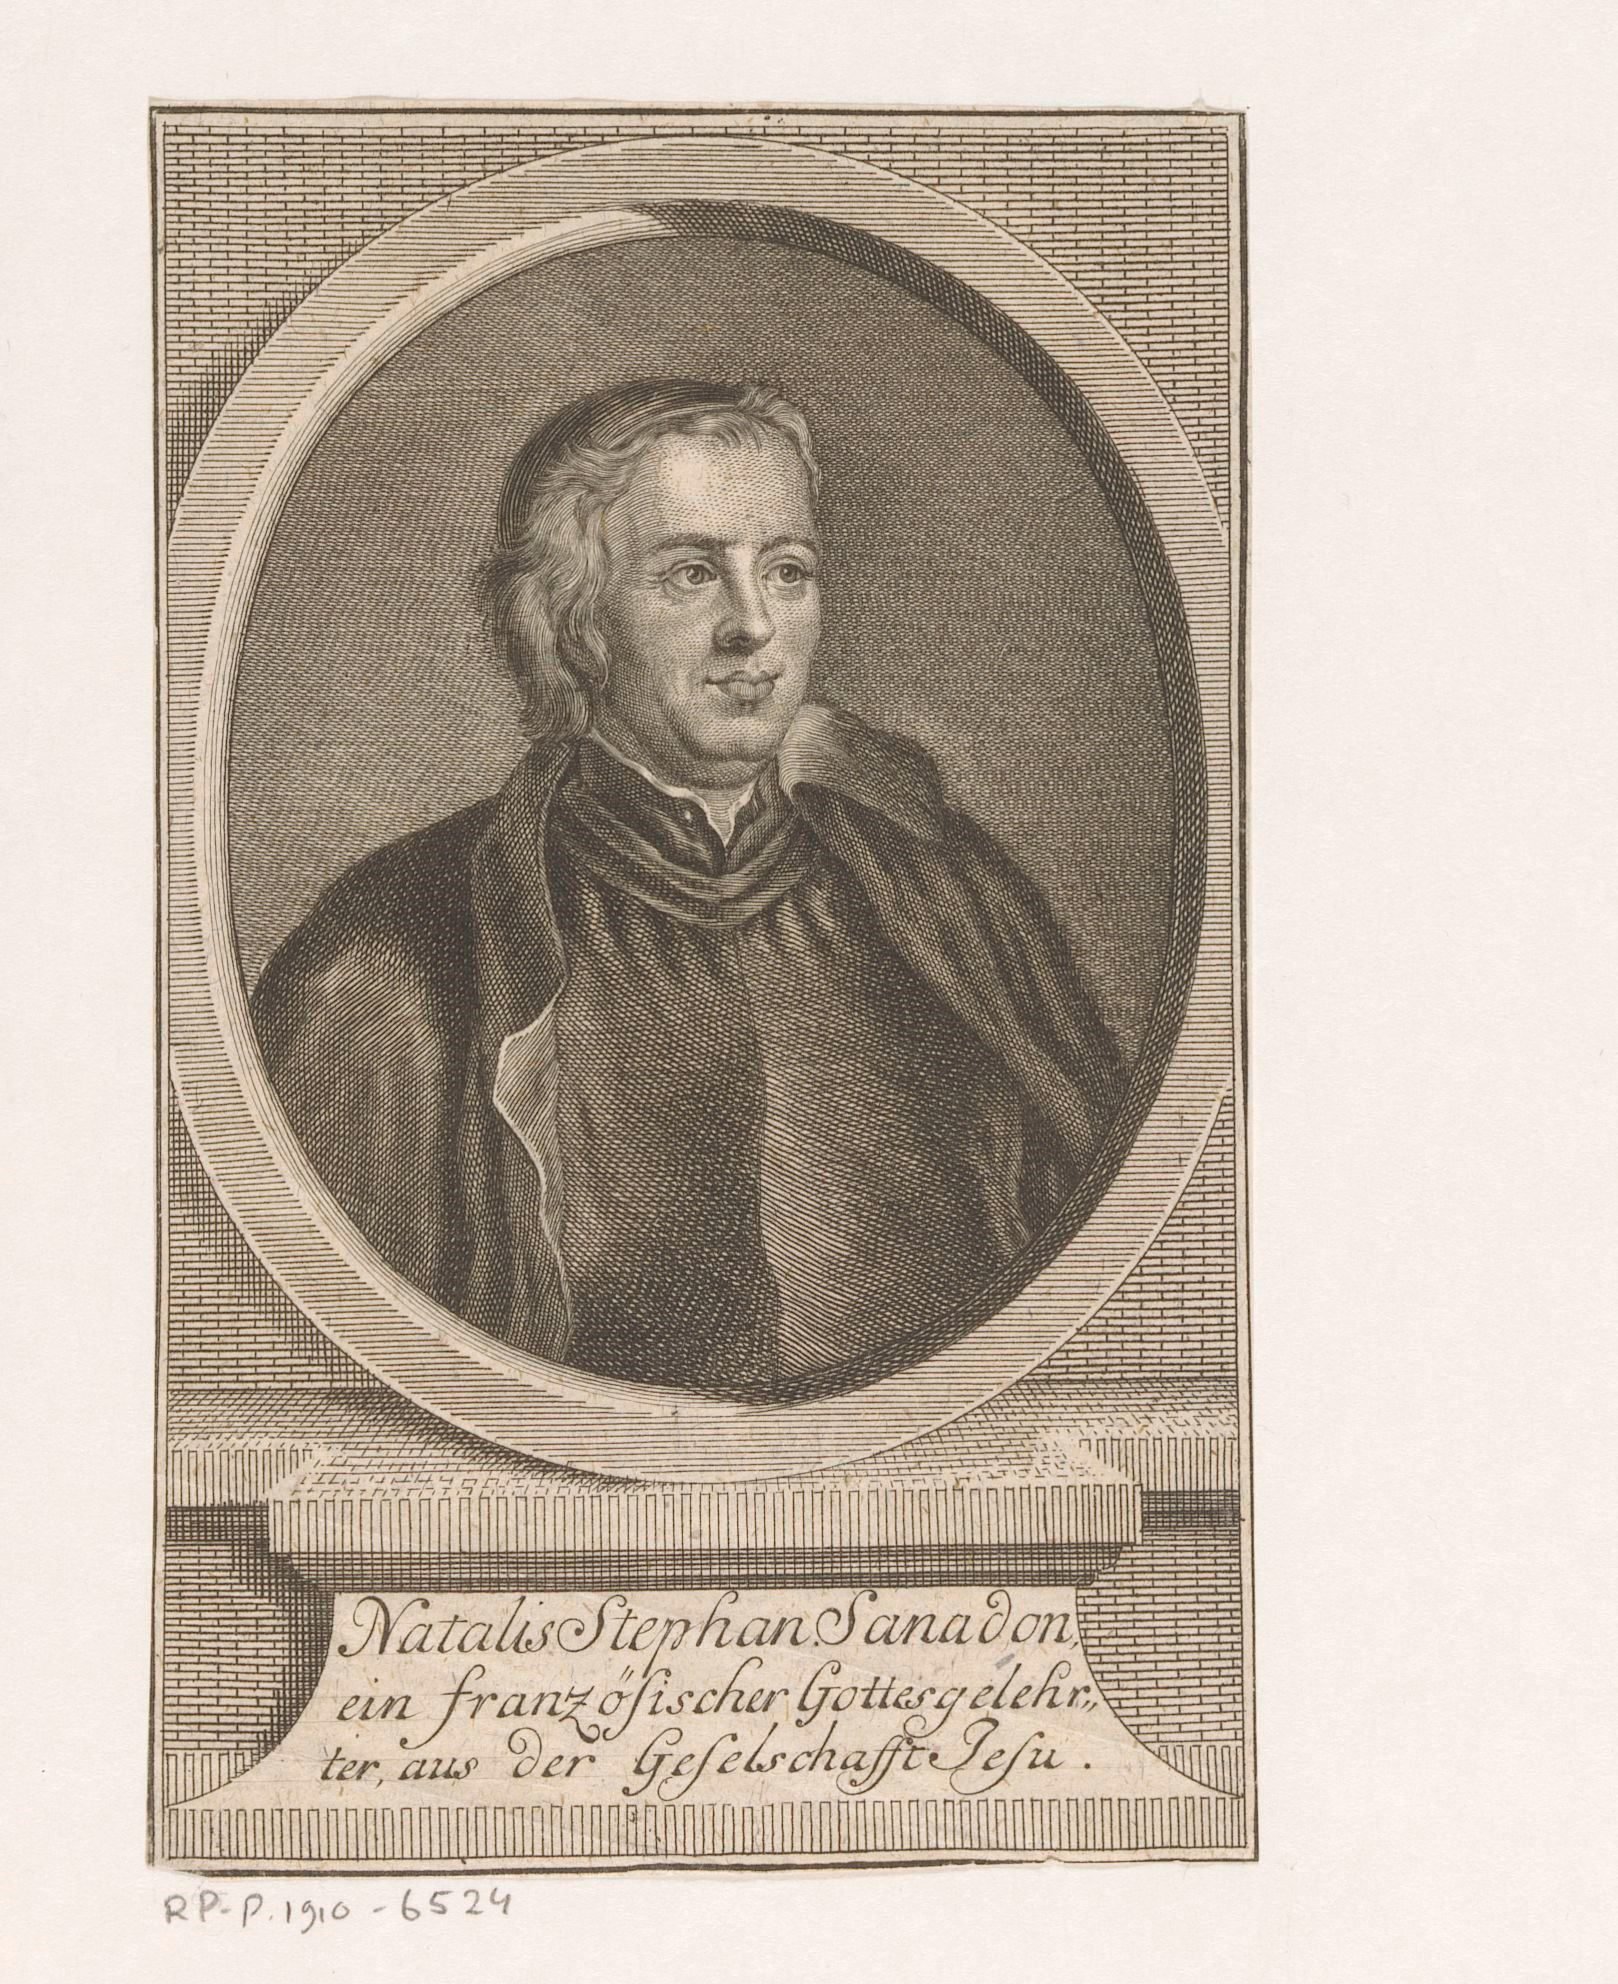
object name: print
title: Portret van Noël-Étienne Sanadon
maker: johann christoph sysang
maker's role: print maker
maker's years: 1703-1757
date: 1723-1767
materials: paper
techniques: engraving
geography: leipzig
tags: paris, historical persons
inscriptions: collector's mark: Lugt 2228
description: Prent gebruikt voor de publicatie: Zuverlässige Nachrichten von dem gegenwärtigen Zustande, Veränderung und Wachsthum der Wissenschaften. dl. 167. Leipzig: Johann Friedrich Gleditsch, 1753.